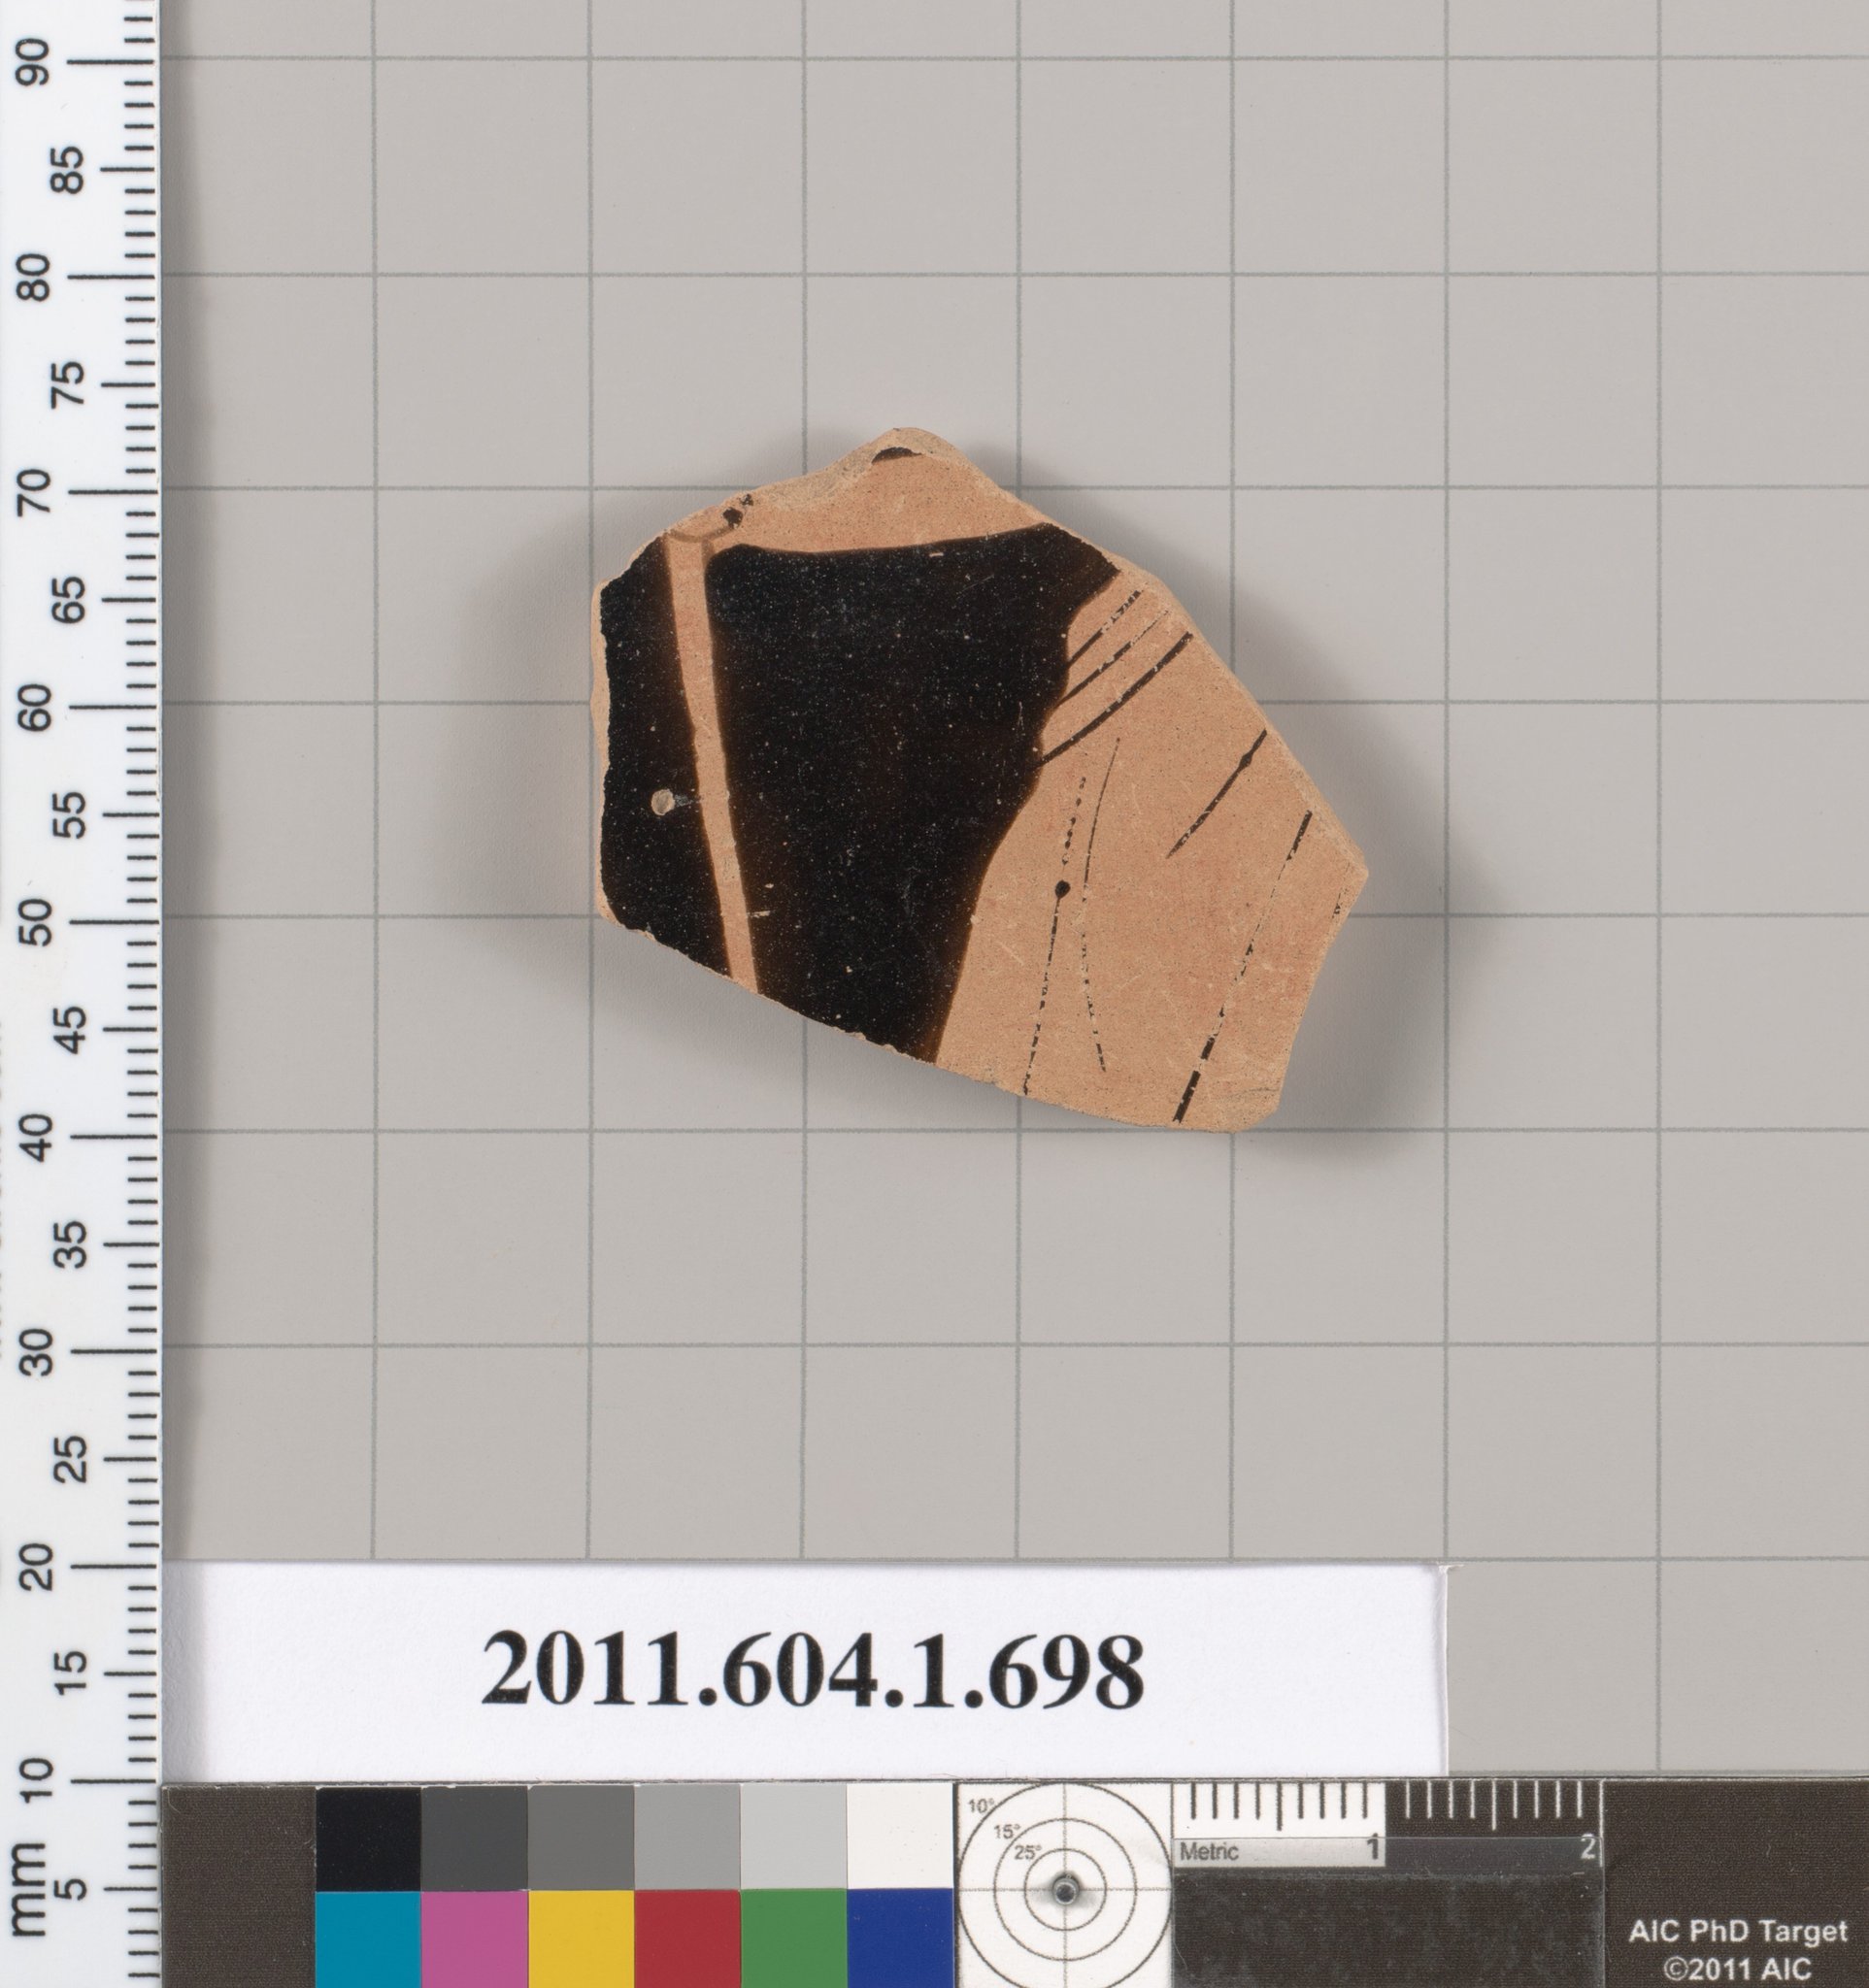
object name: kylix fragment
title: Terracotta fragment of a kylix (drinking cup)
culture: greek, attic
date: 475-451 BCE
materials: terracotta